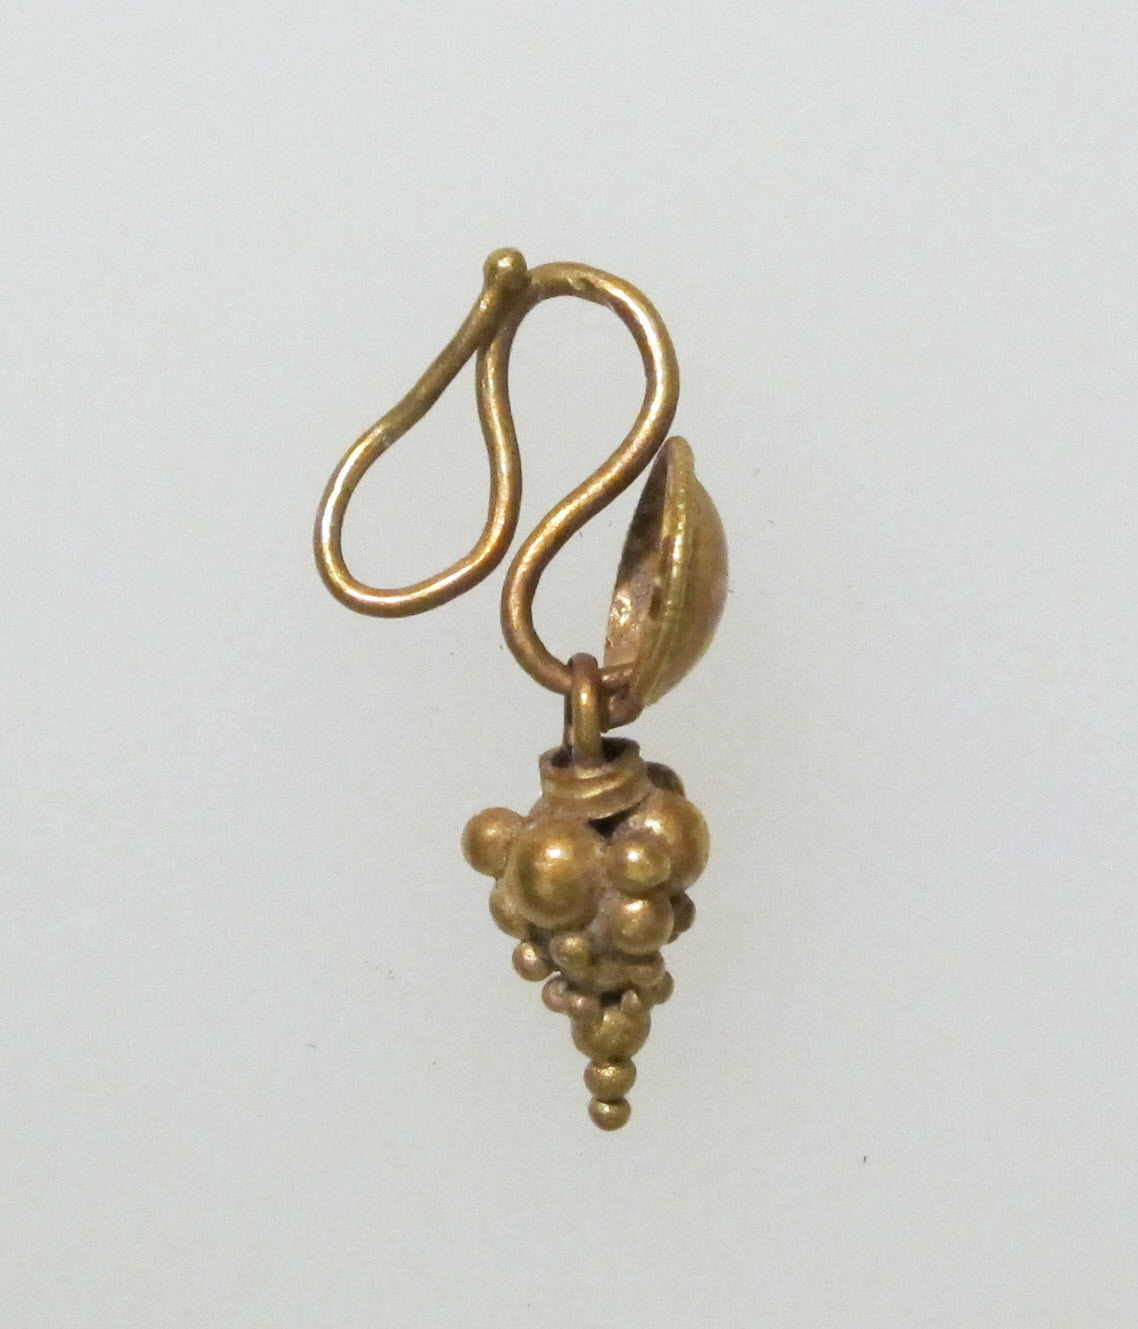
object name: earring hook type with pendant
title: Earring-hook type, with disc and pendant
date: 7000 BCE-330 CE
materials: gold